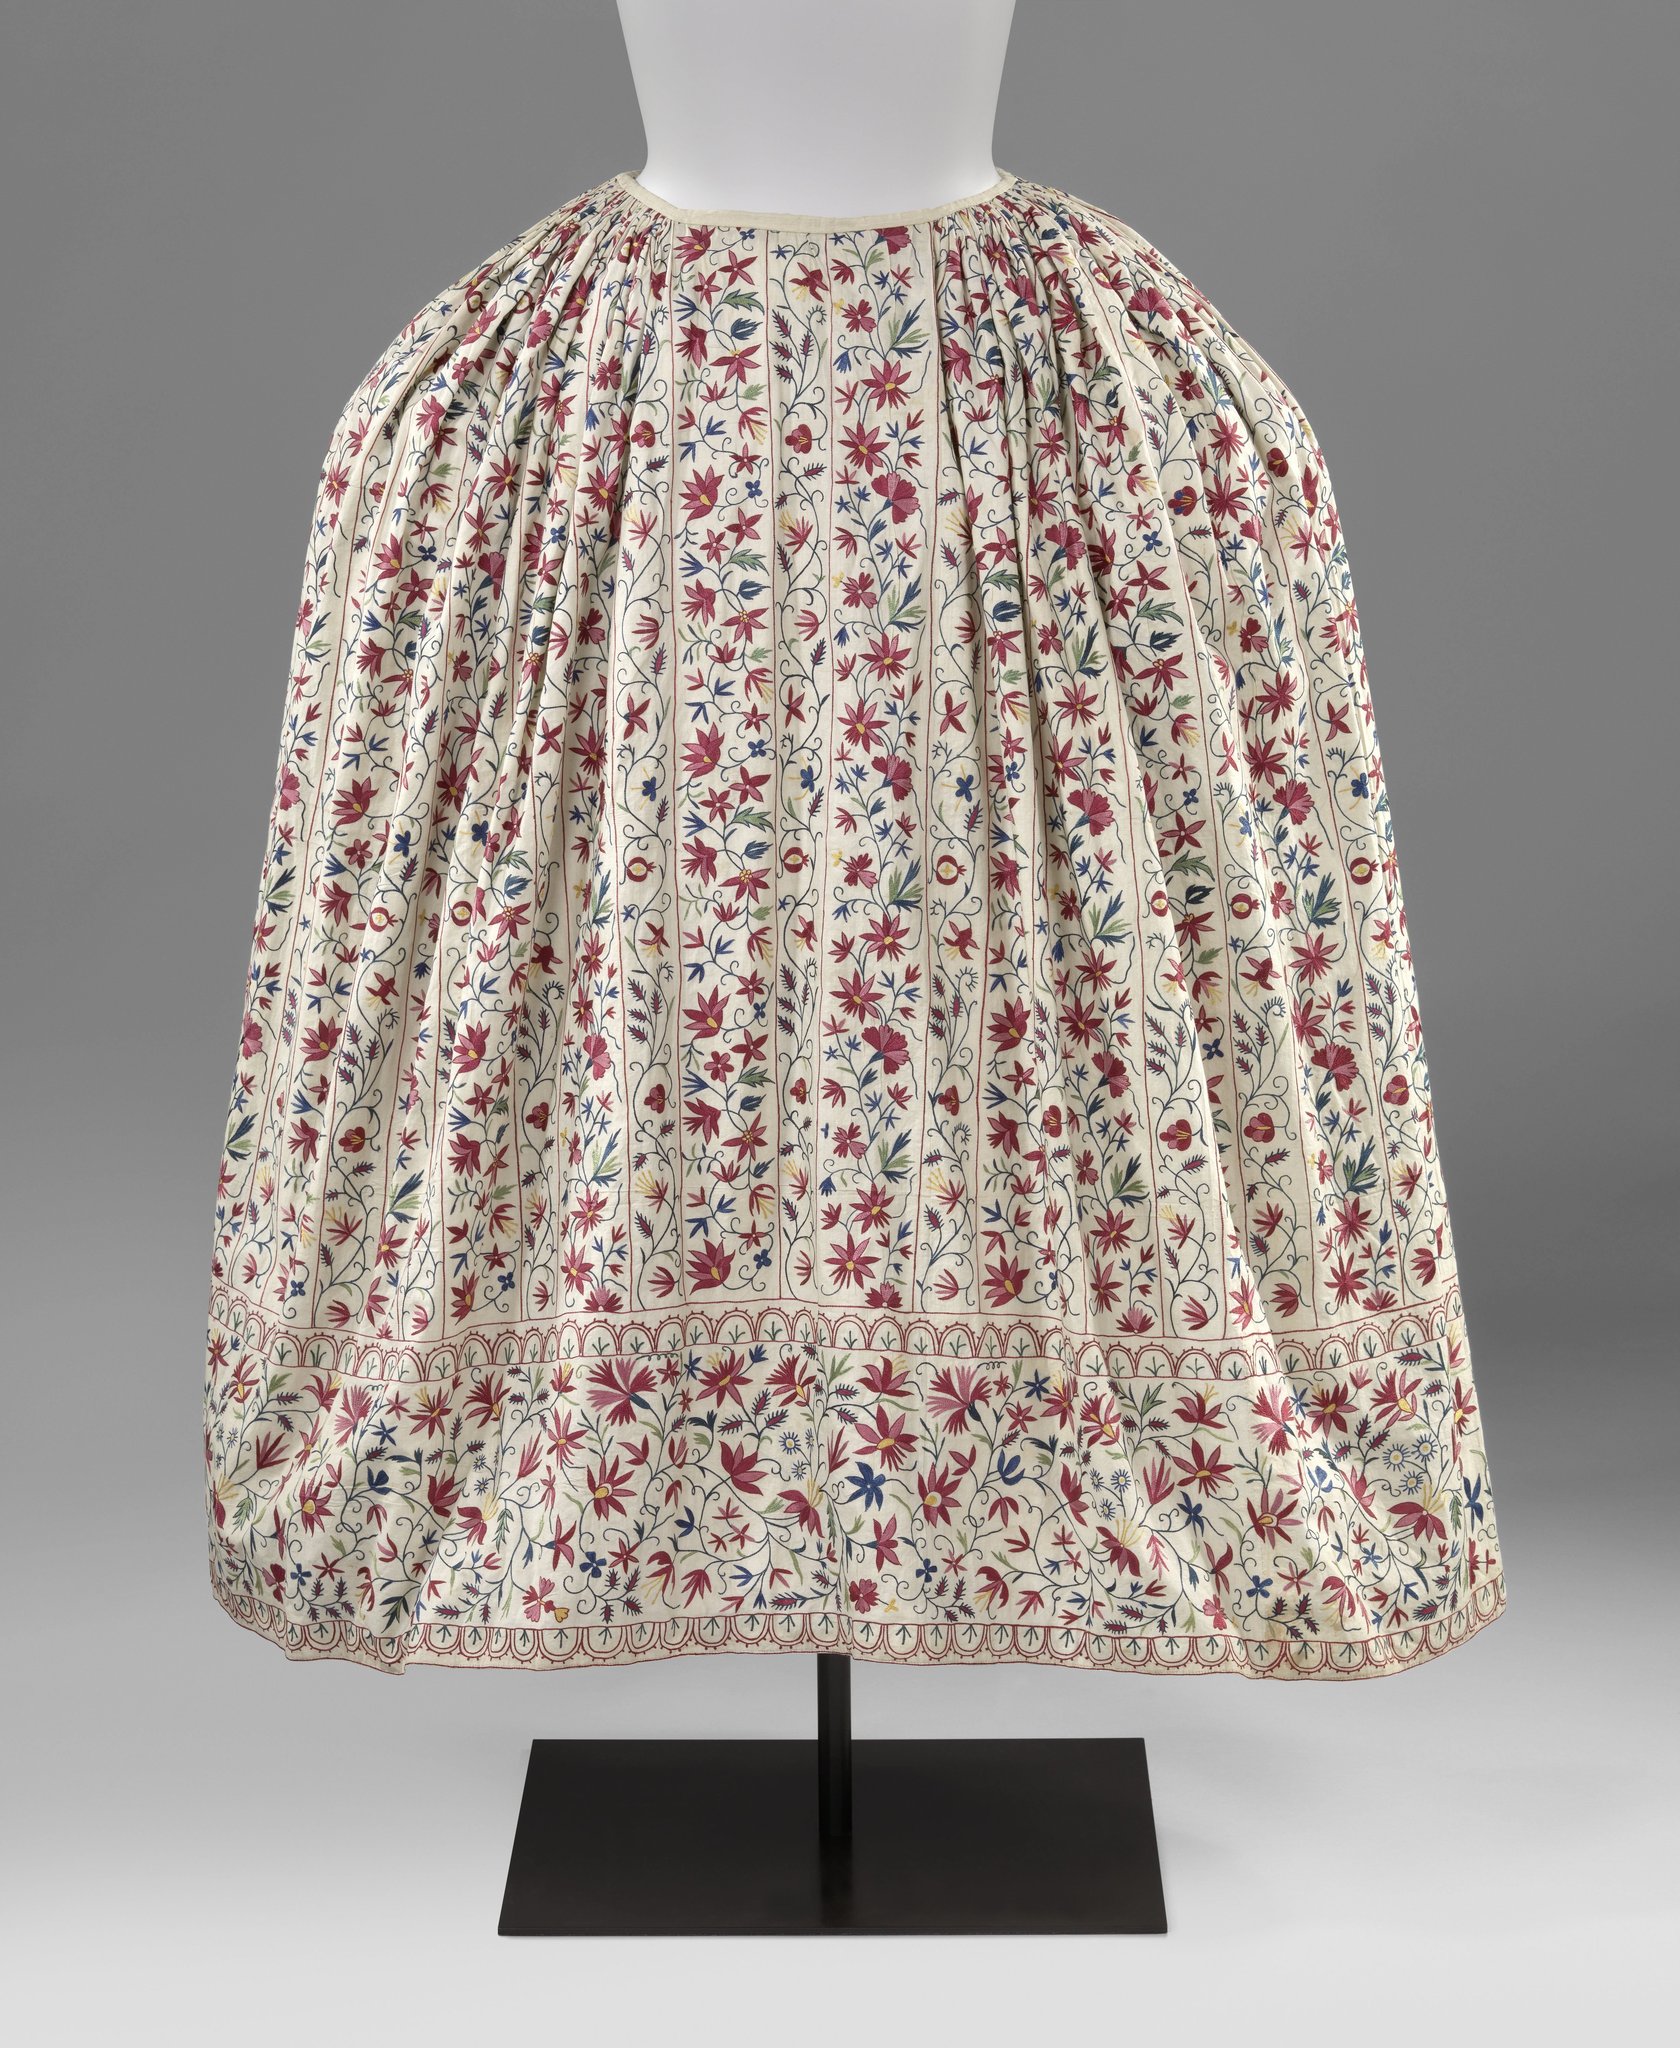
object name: main garment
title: Rok van wit katoen met verticale strepen en een brede onderrand van getamboereerde meerkleurige bloem- en bladranken, gescheiden door strepen of gestileerde sierranden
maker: Anonymous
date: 1740-1760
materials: cotton, linen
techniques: embroidered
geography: india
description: Rok van roodgetamboureerde witte katoen. Rechte rok van drie stofbanen. Op het midden is van voren, bij het middel, een breed stuk glad gehouden, aan de achterzijde een kleiner stuk, waarnaast de stof, met voering, is ingerimpeld. Daarover een beige boorlintje. Rok versierd met patronen van bloem-, voluut- en spiraalranken. Geheel gevoerd met wit linnen.